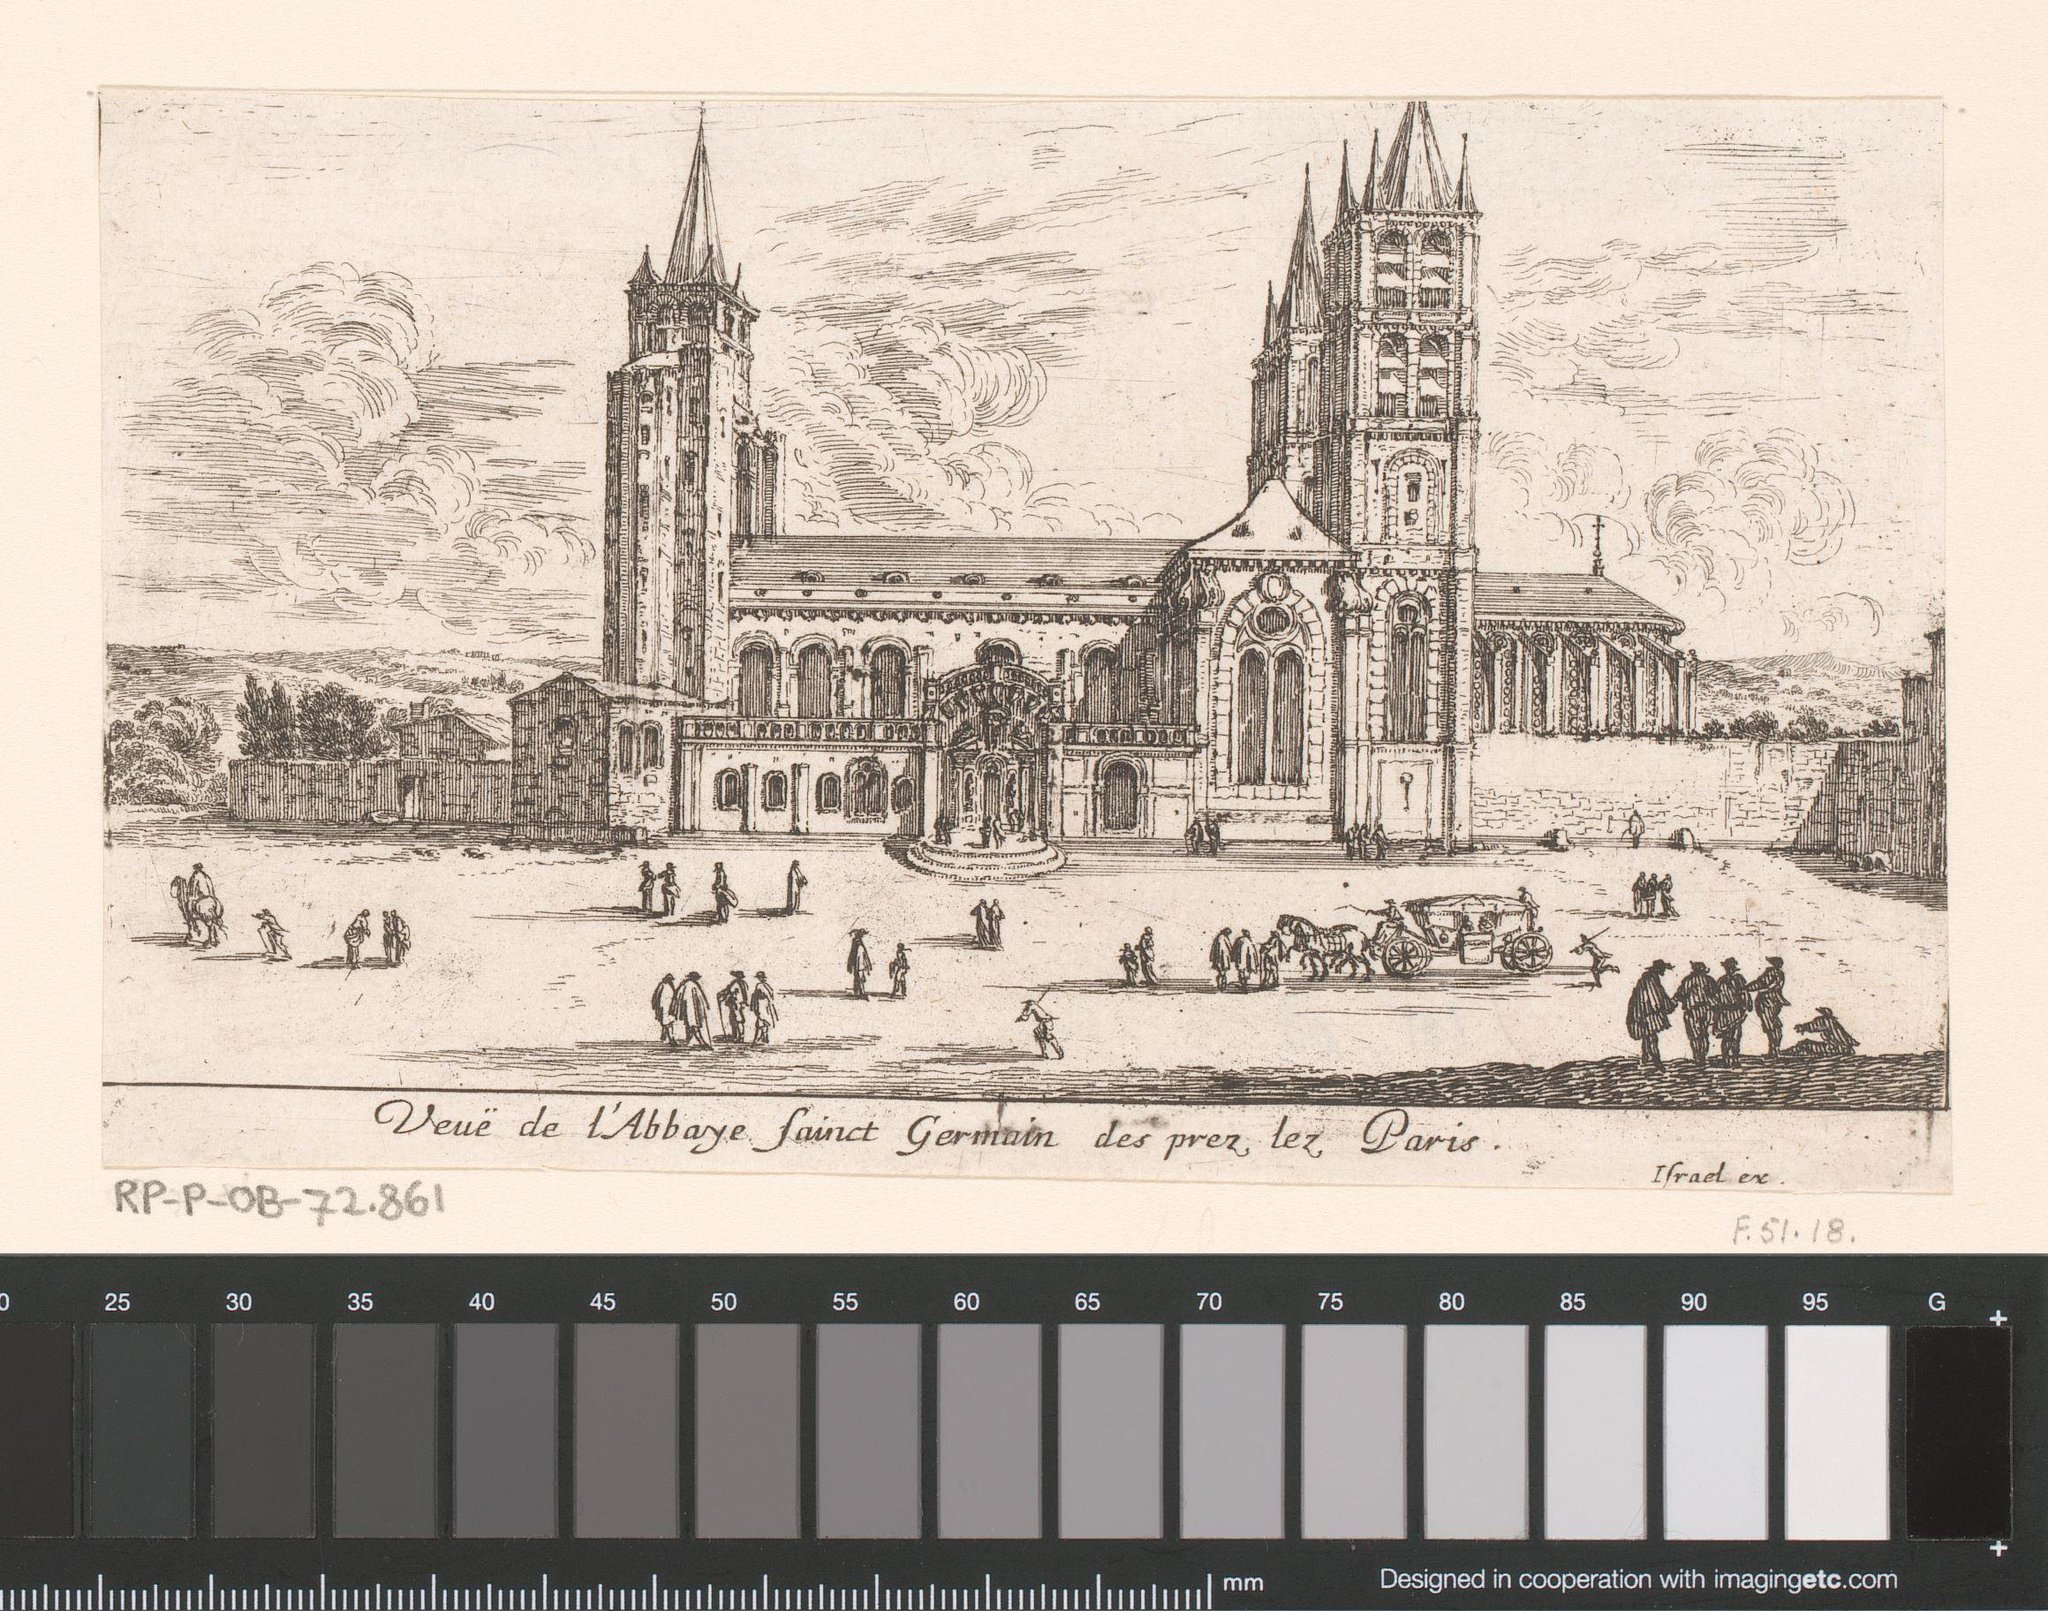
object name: print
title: Veue de l'Abbaye Sainct Germain des prez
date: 1652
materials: paper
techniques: etching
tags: abbey, monastery, convent ~ roman catholic church, landscape with tower or castle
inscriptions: collector's mark: Lugt 240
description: Prent maakt deel uit van een ongenummerde serie van twintig prenten.